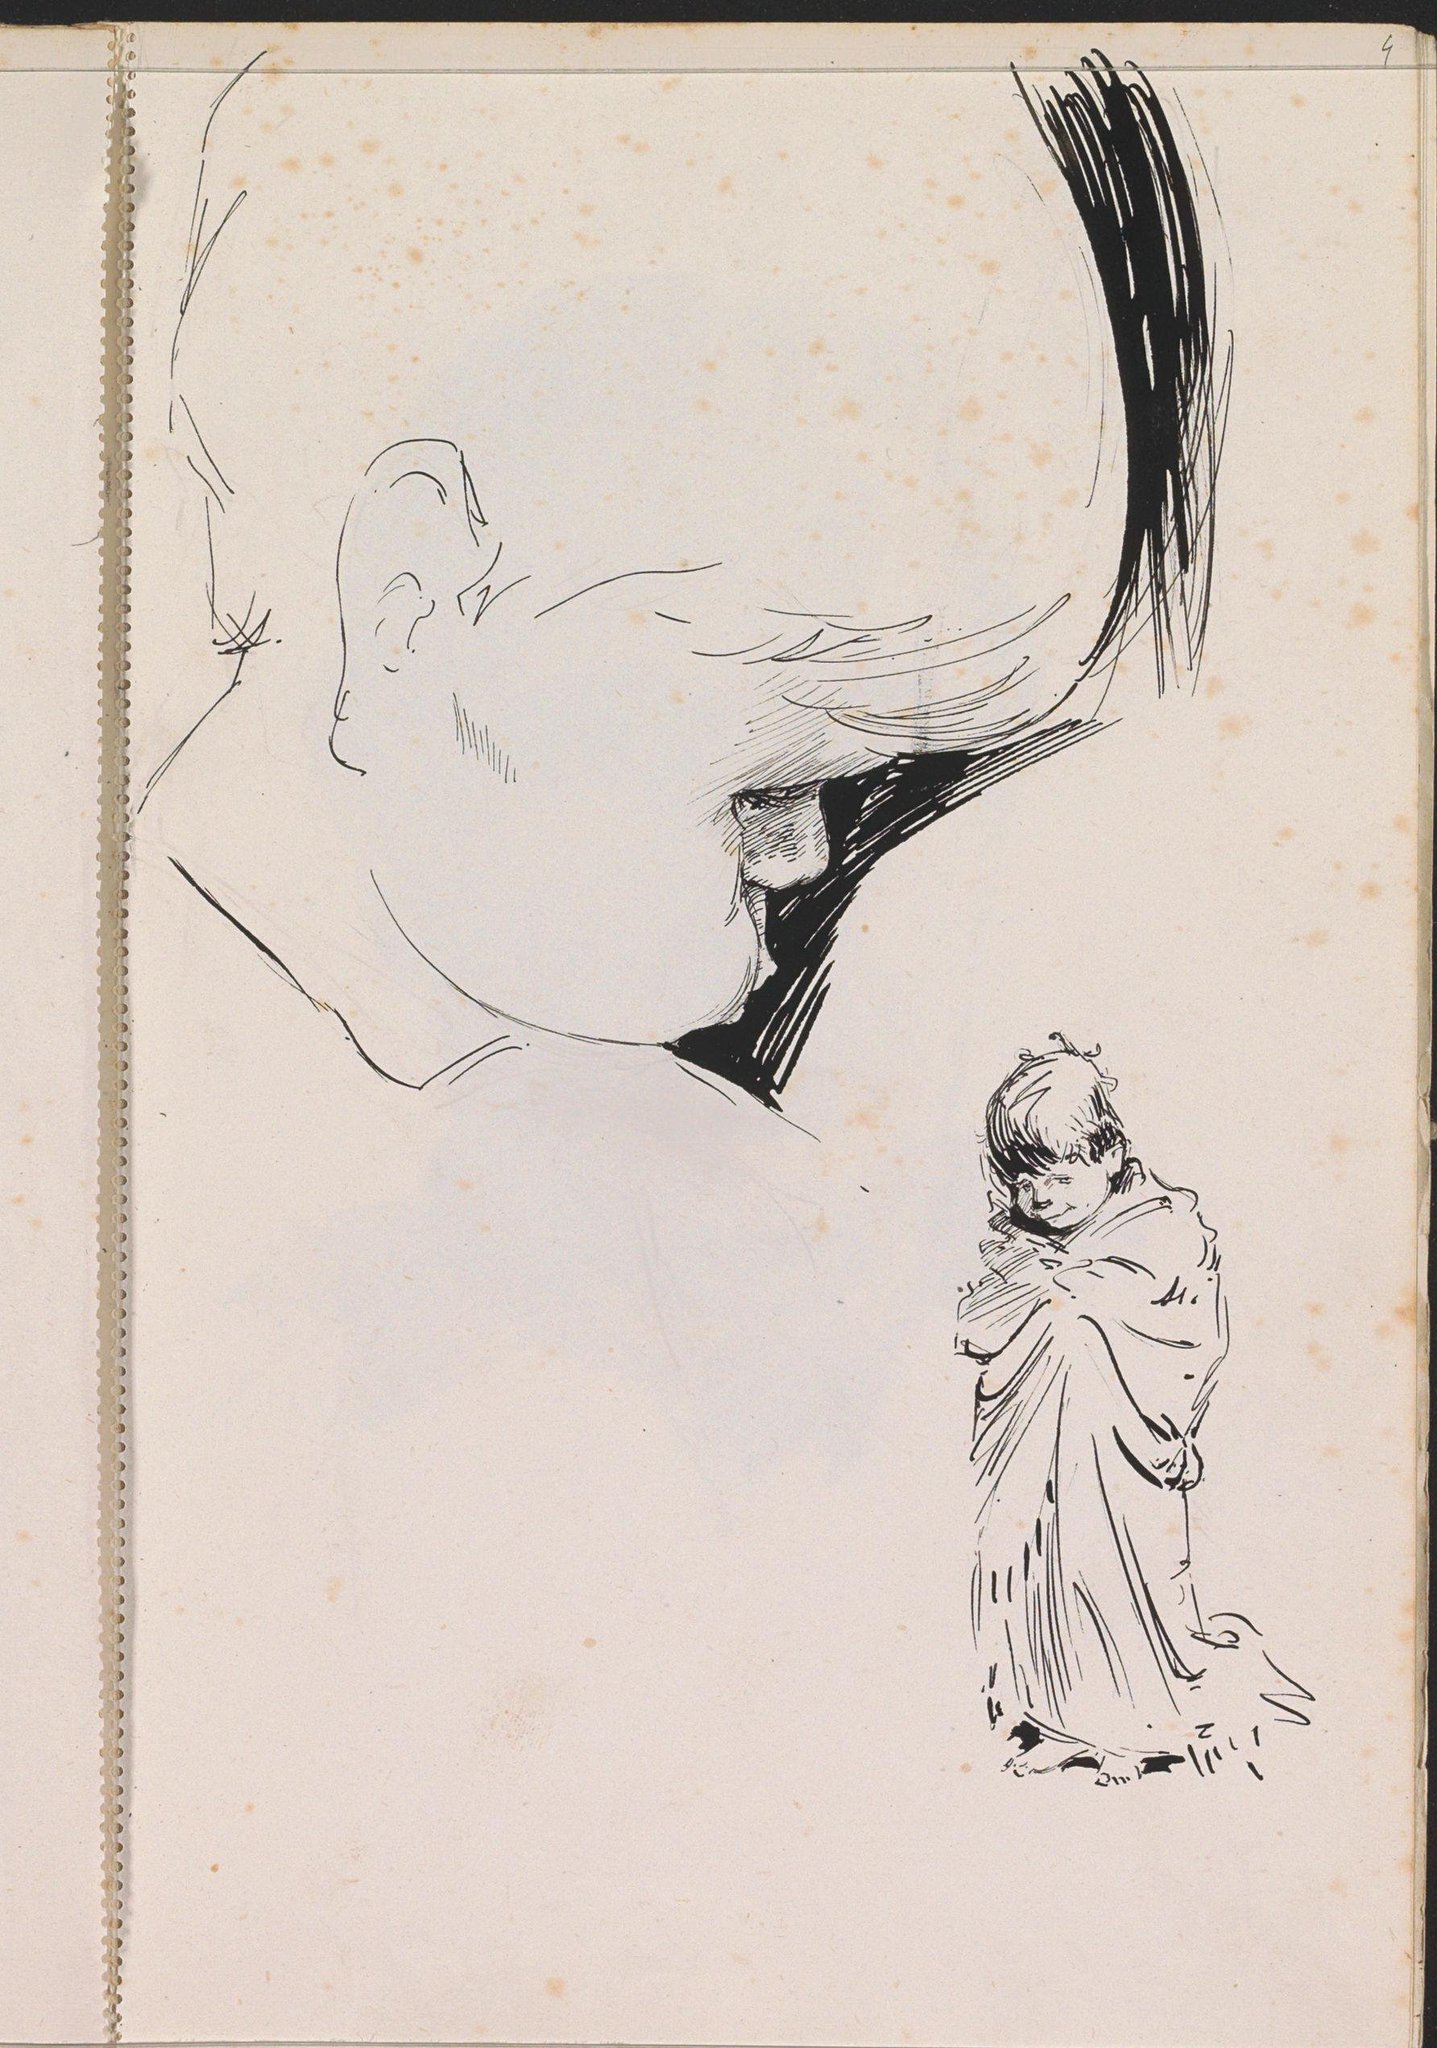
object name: sketchbook leaf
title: Jongen met een deken om zich heen geslagen en een hoofd van een kind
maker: otto verhagen (i)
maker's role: draughtsman, print maker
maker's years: 1885-1951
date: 1922-1925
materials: ink, paper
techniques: pen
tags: head (human) (+ right side visible; right - (r. hand, r. foot, etc.)), boy (child between toddler and youth)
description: Pagina 4 uit een schetsboek met 34 bladen.